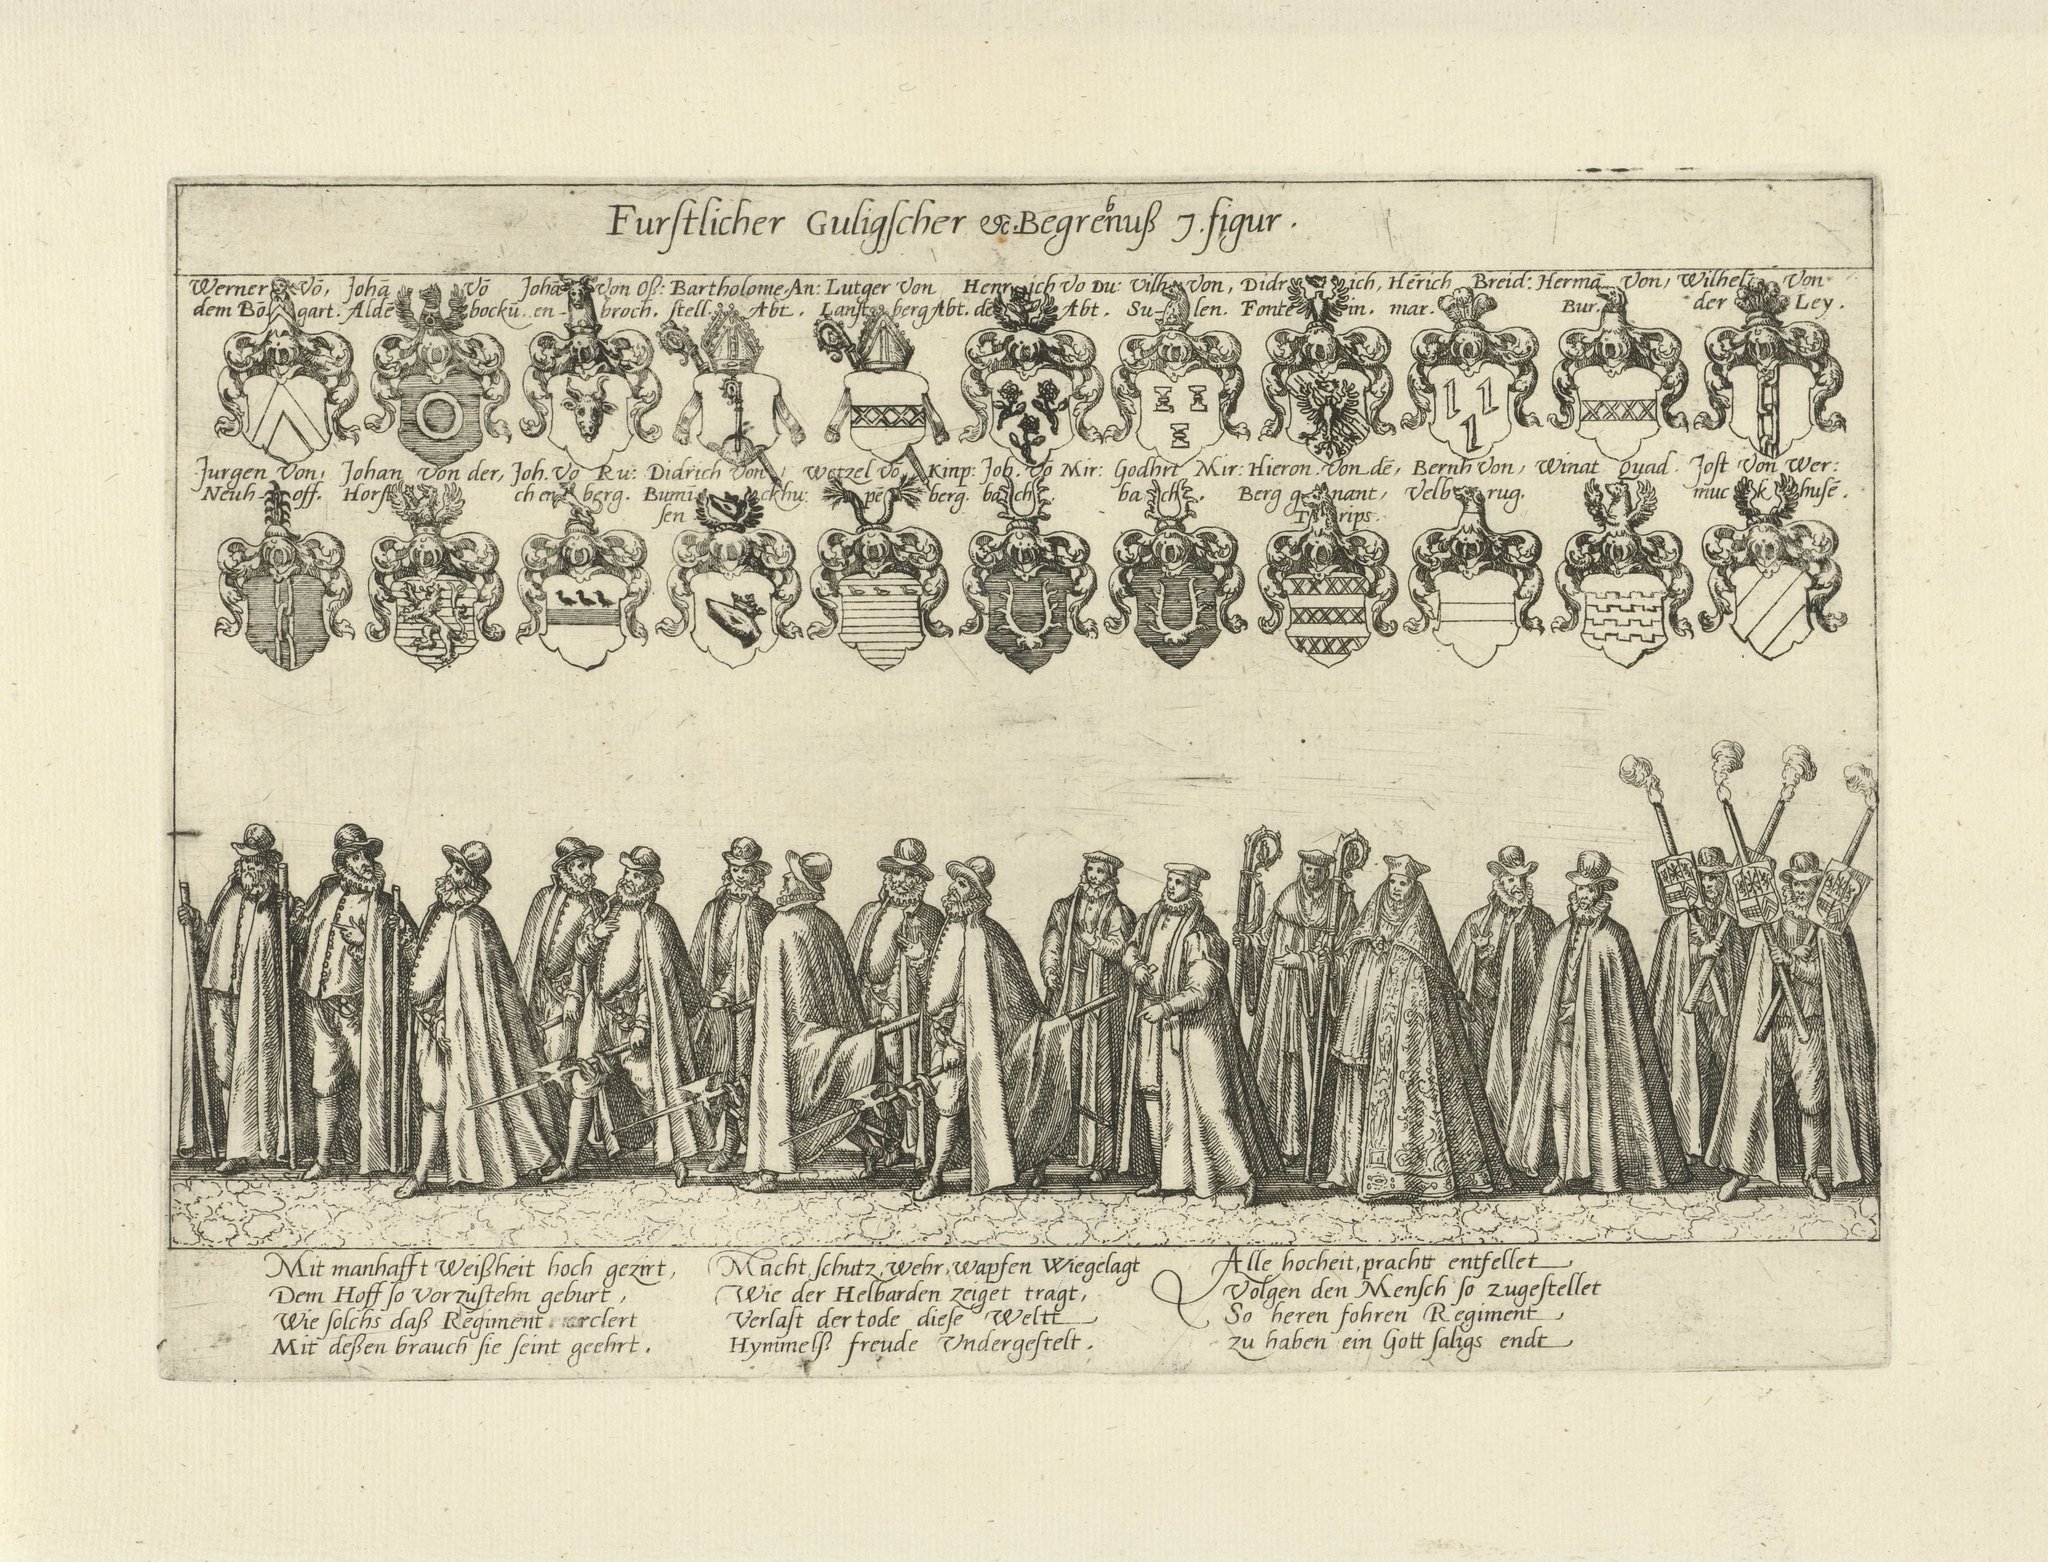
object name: print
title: Begrafenisstoet met hellebaarders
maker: Anonymous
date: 1592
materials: paper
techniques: etching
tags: funerary ceremonial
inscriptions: collector's mark: Lugt 2228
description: Prent ook gebruikt in: Graminaeus, Theodor. Spiegel vnd abbildung der Vergengligkeit: Darinnen was der Toden Recht vnd Geburnuß begriffen ... Vnd wie der Durchleuchtiger ... Herr Johan Wilhelm Hertzog zu Gülich, Cleue vnd Berg ... da jhr F.G. Herr Vatter Christmilter gedechtnuß, Hertzog Wilhelm ... im Jahr 1592. ... entschlaffen, ... am zehenden Tag Martij in der Collegiat Kirchen zu Düsseldorff ... begraben ... lassen. Keulen: Theodor Graminaeus, 1592.